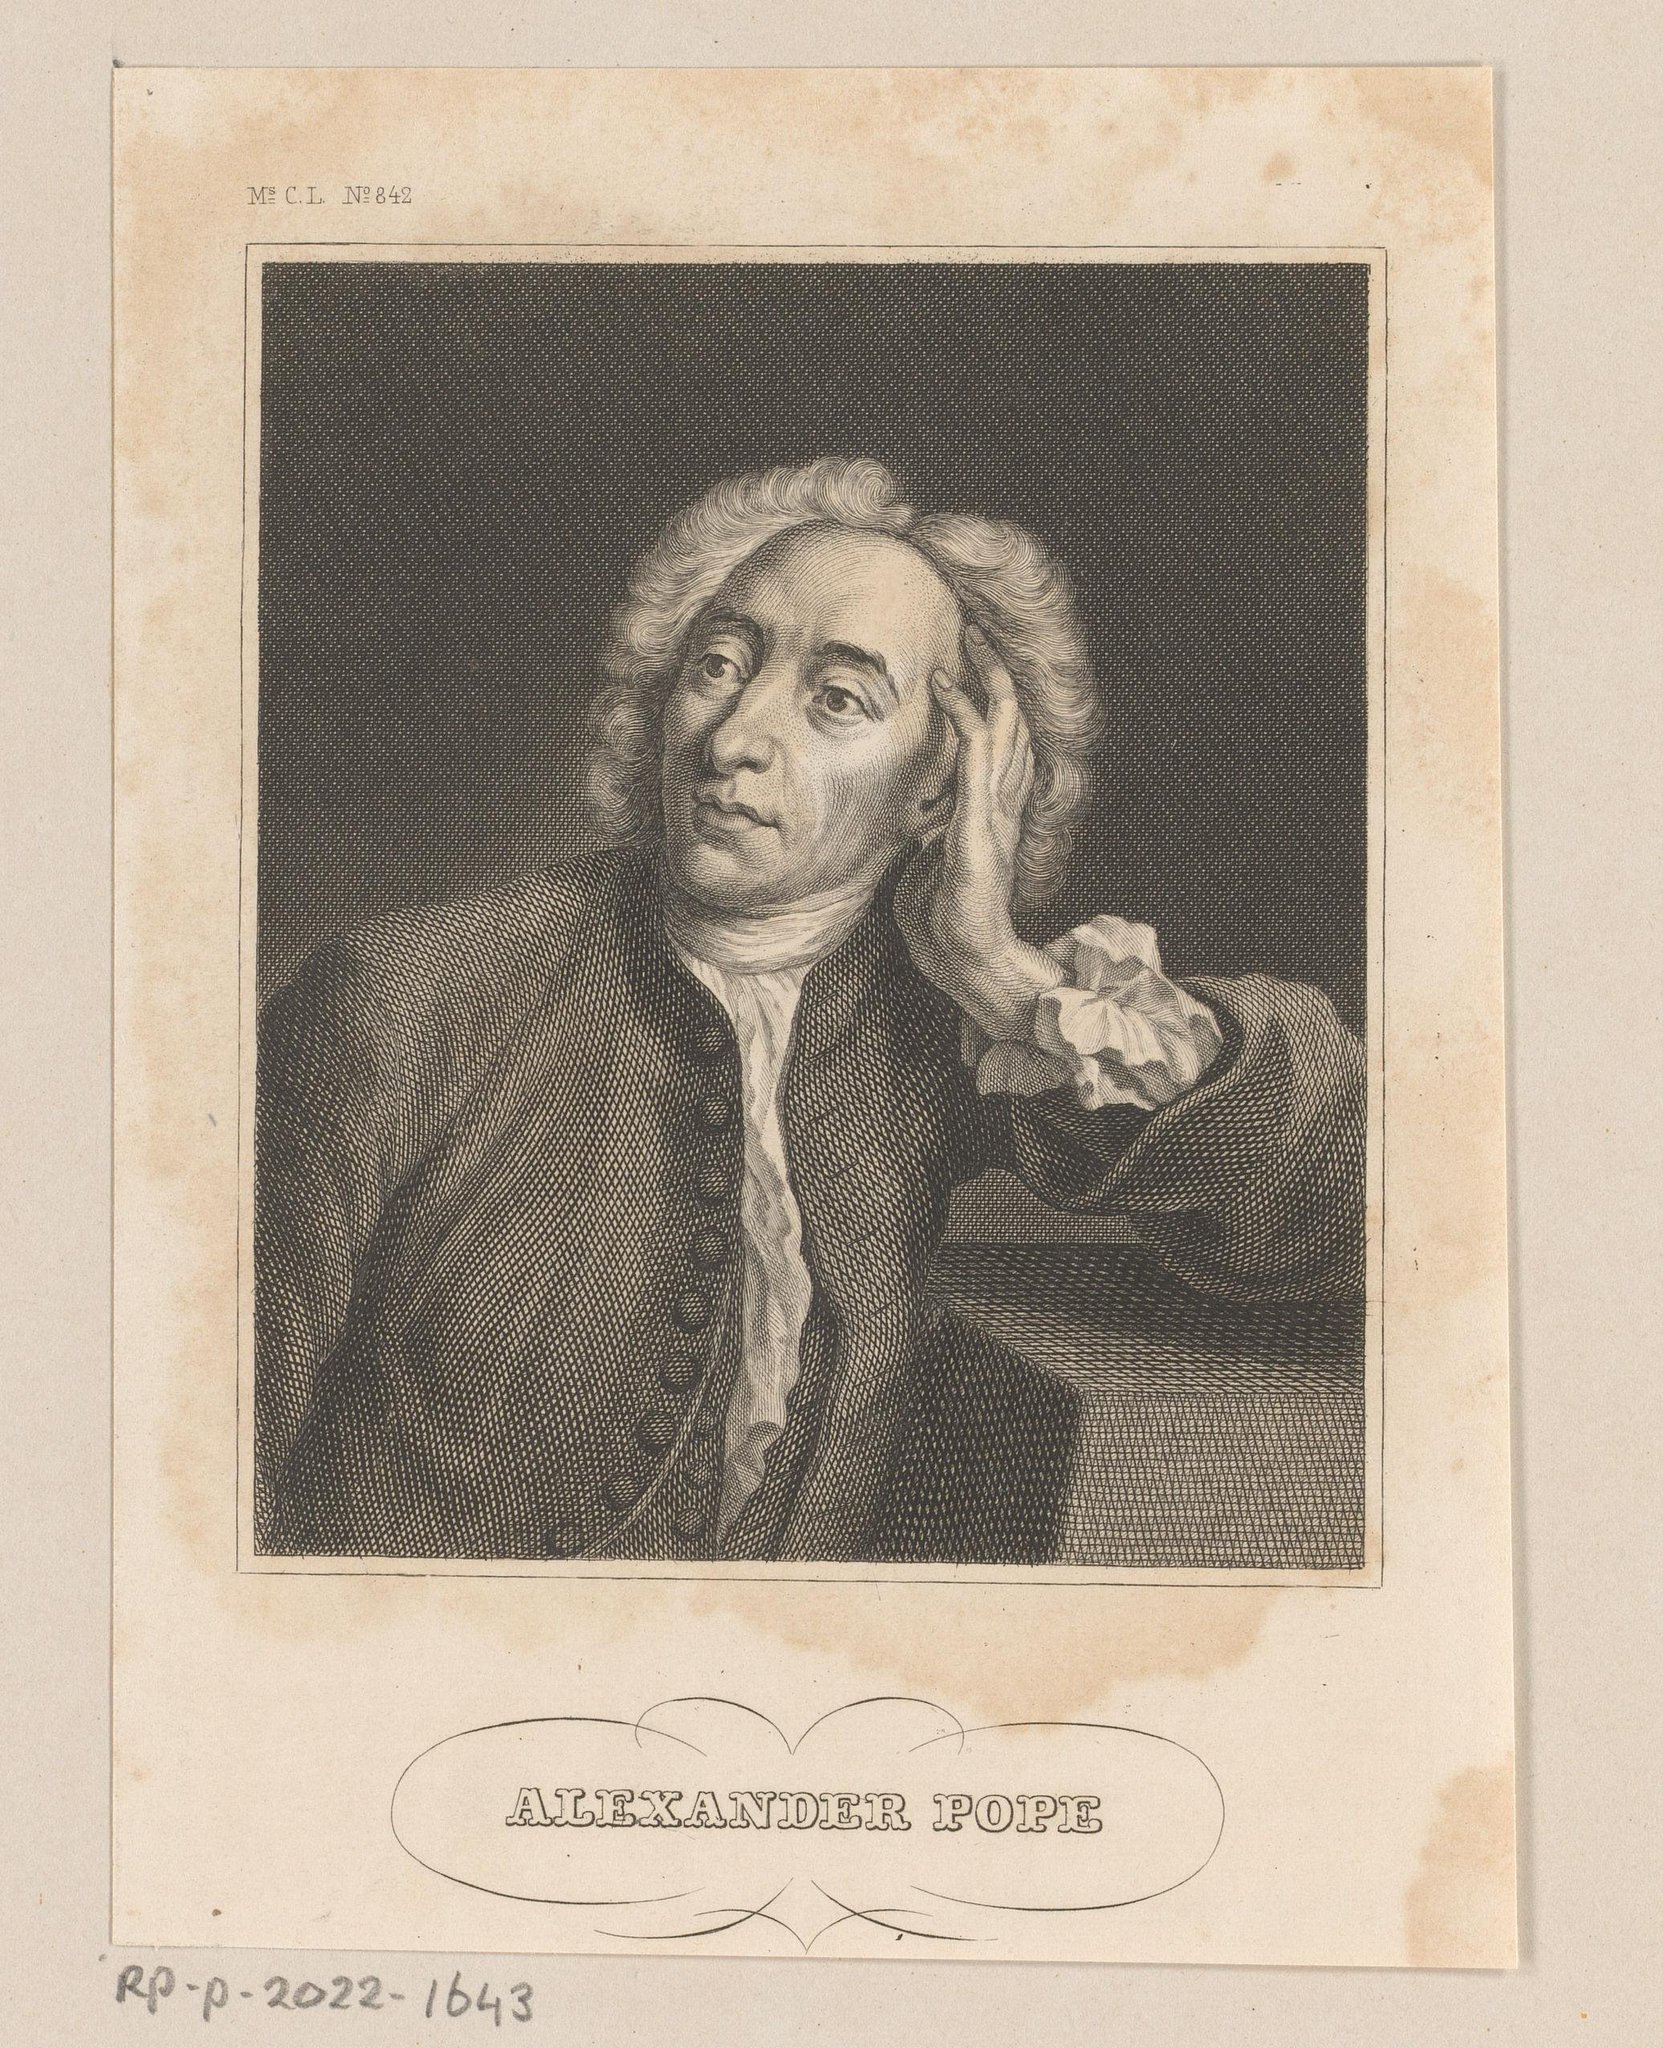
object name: print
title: Portret van Alexander Pope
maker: Anonymous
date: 1828-1852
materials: paper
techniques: engraving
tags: london, alexander pope, historical persons, writer, poet, author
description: Prent uit: Meyer, Joseph. Das große Conversations-Lexikon für die gebildeten Stände. 52 dln. Hildburghausen: Bibliographisches Institut, [1828-1852].